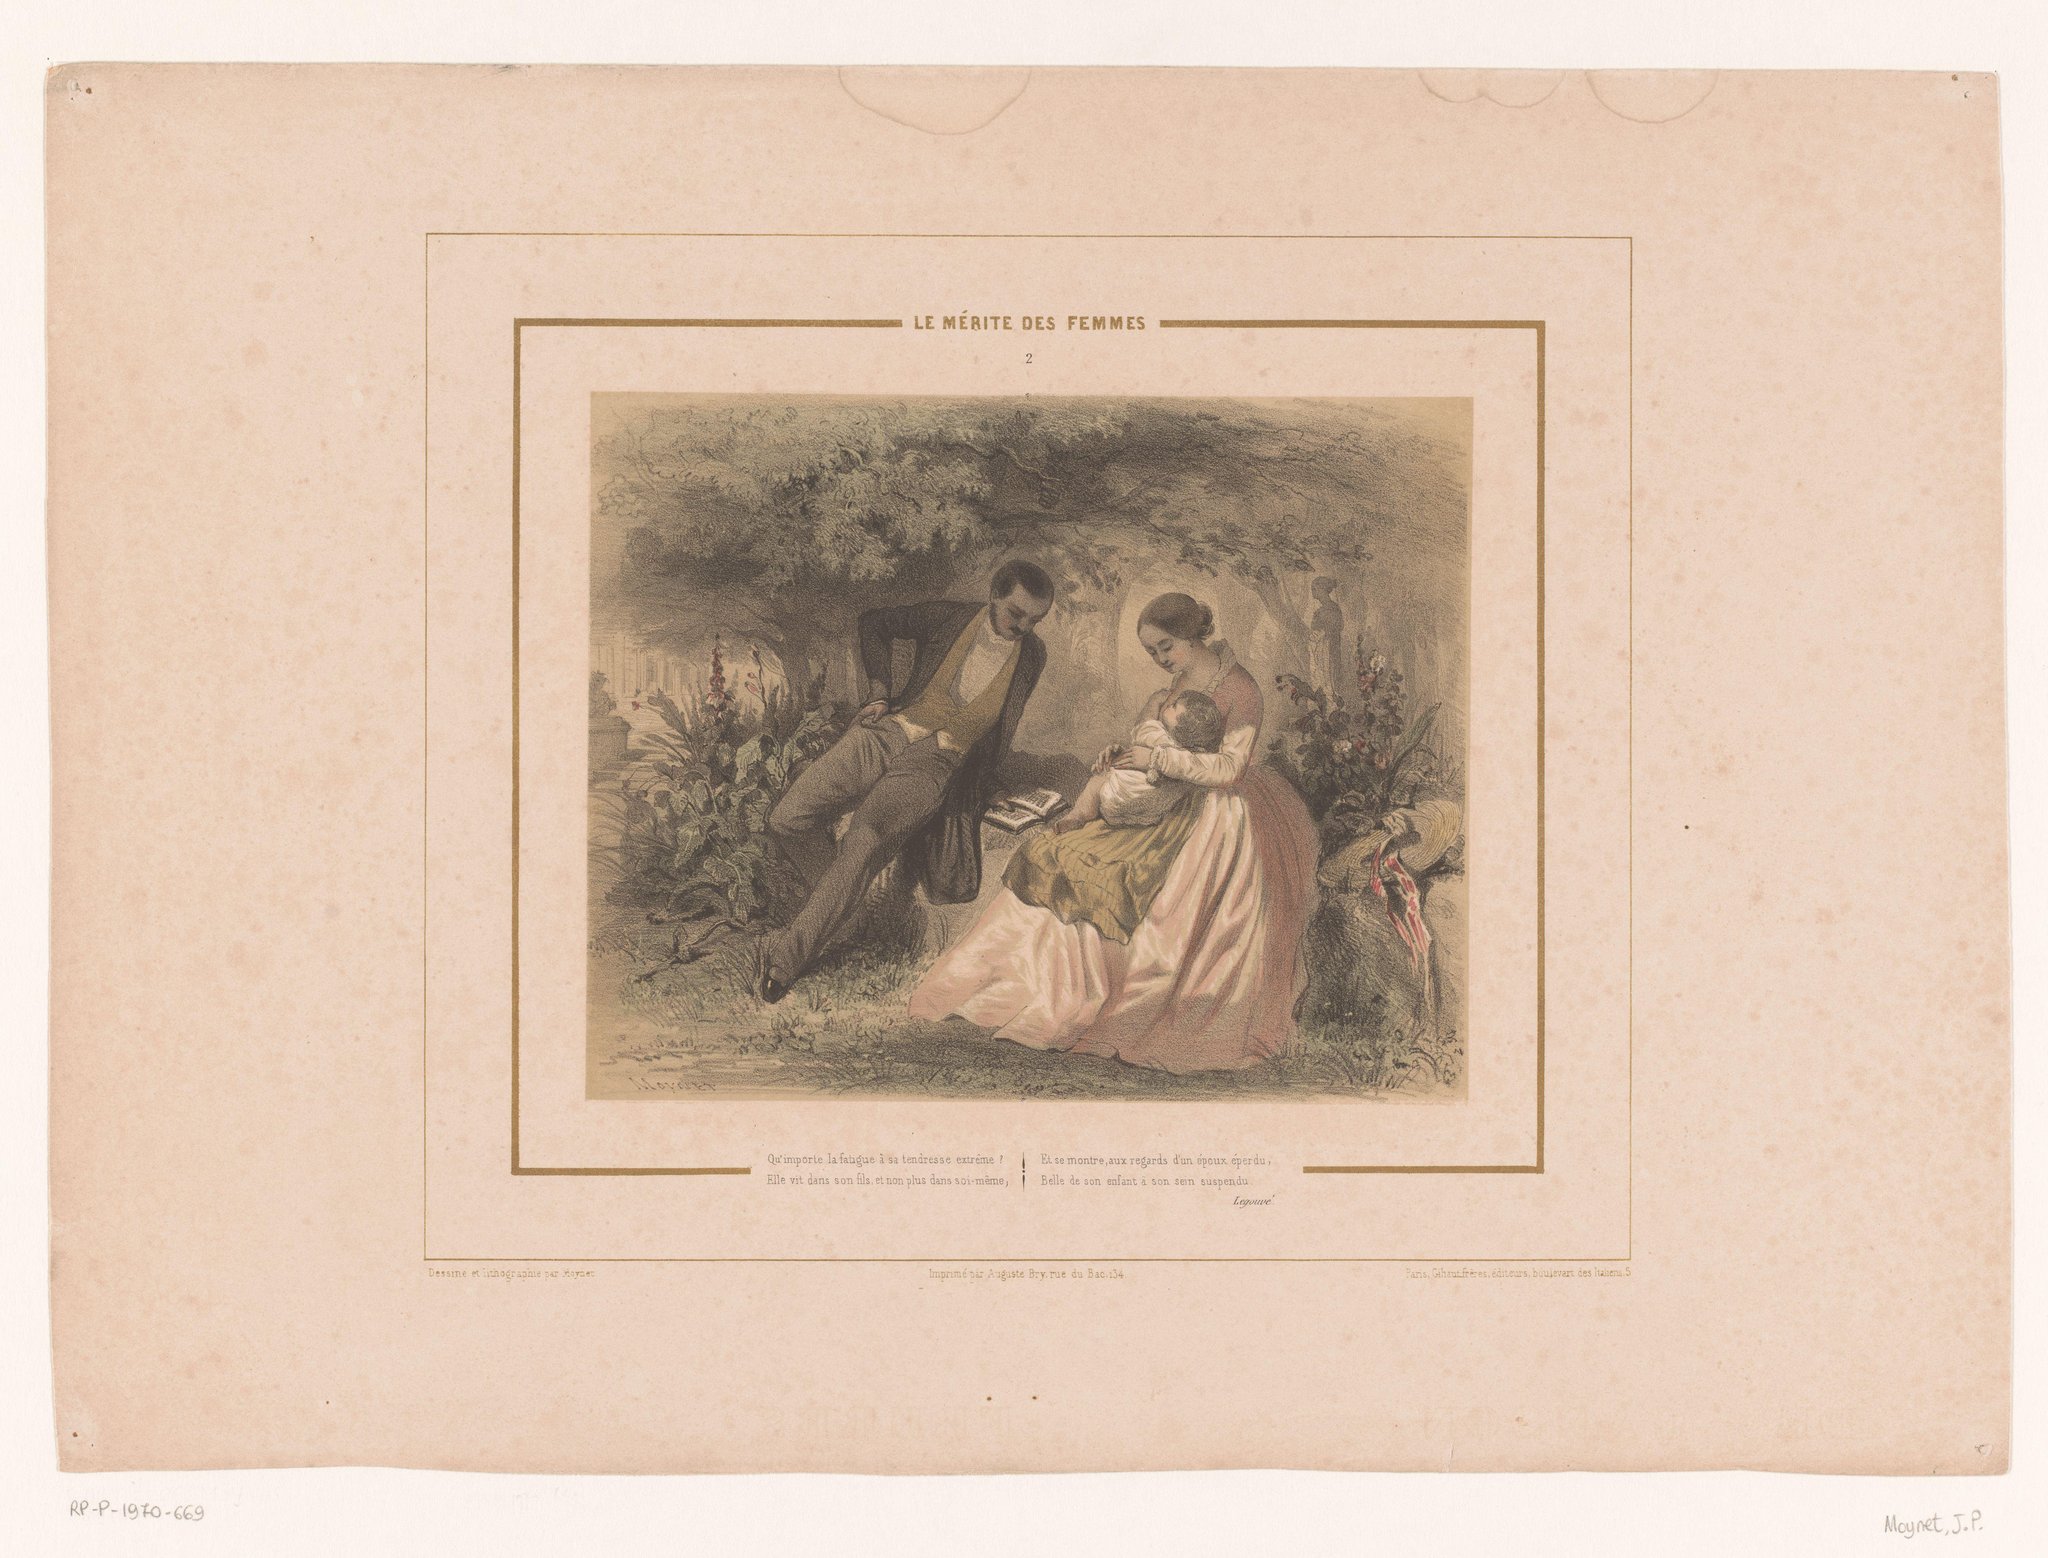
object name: print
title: Le mérite des femmes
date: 1831-1871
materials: paper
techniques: hand coloring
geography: paris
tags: forest, wood, family life, infant, baby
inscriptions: collector's mark: Lugt 2228, inscription: ‘v. Stockum, 24 Nov. 1964/ No. 172 (81 st.) f. 520-’, watermark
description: Onder een deel van het gedicht 'Le mérite des femmes' van Gabriel-Marie Legouvé: Qu'importe la fatigue à sa tendresse extrême? Elle vit dans son fils, et non plus dans soi-même, Et se montre, aux regards d'un époux éperdu, Belle de son enfant son sein suspendu.